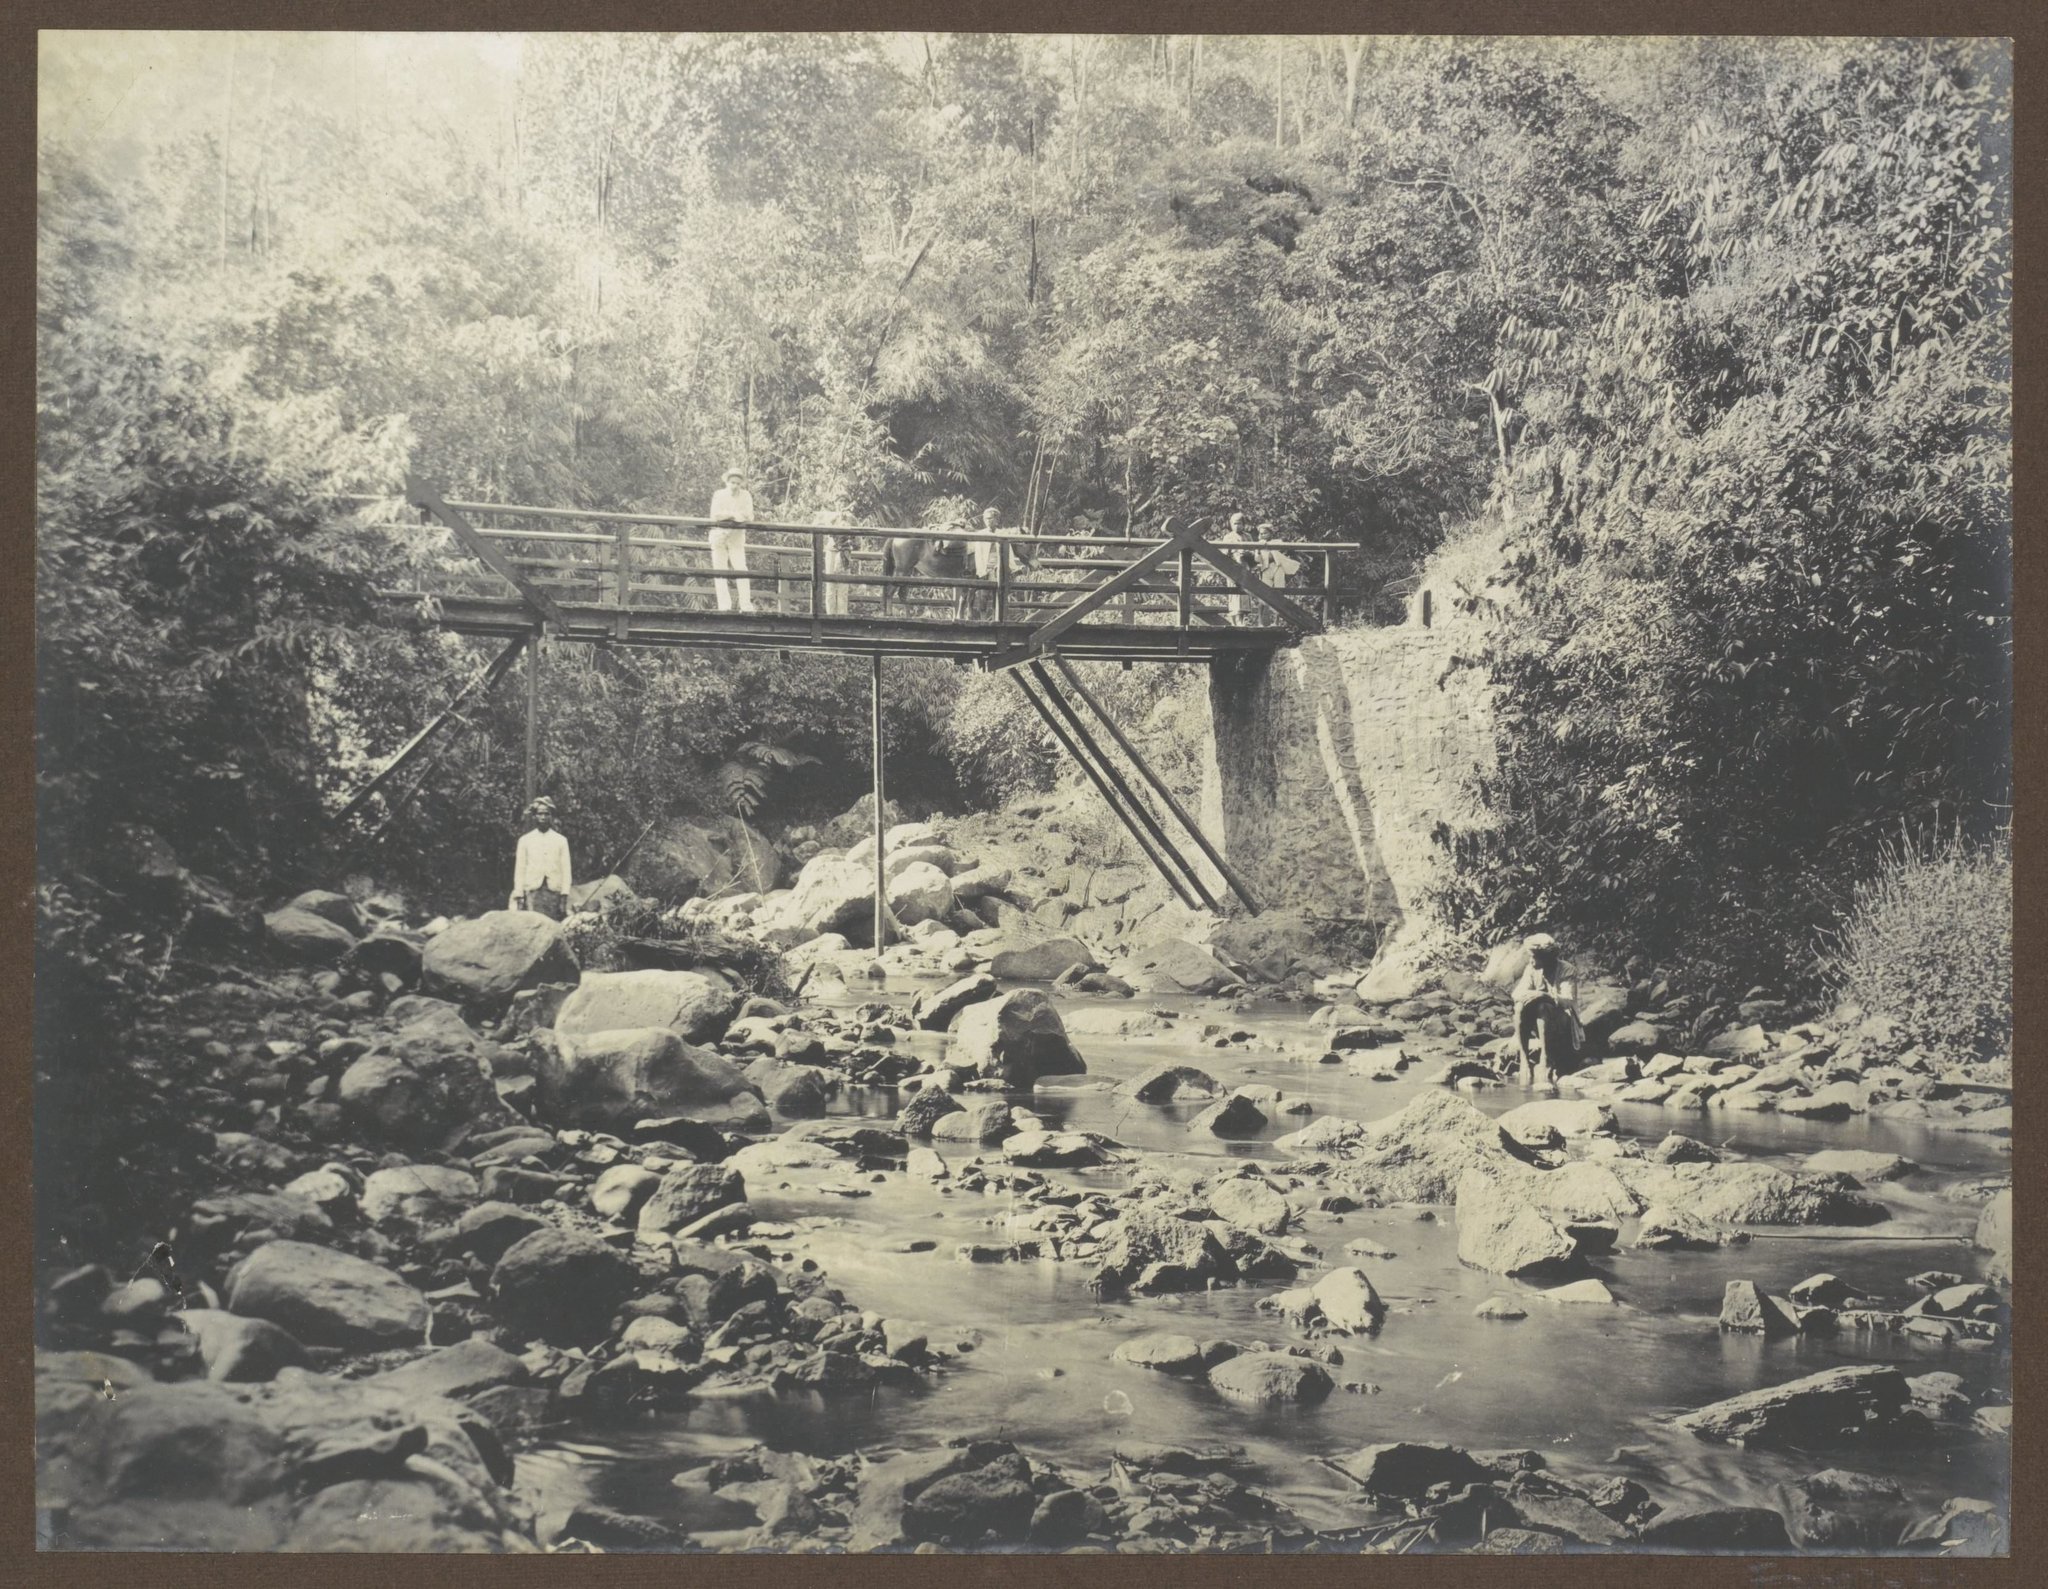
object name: photograph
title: Houten brug over een beek met Indische mensen en (vermoedelijk) een Nederlander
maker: Anonymous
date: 1880-1900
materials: paper, photographic support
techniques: gelatin silver print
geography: dutch east indies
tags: landscape with bridge, viaduct or aqueduct, dutch east indies, the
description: Onderdeel van Reisalbum met foto's van Duitsland, Zwitserland, het Suezkanaal en Nederlands-Indië.